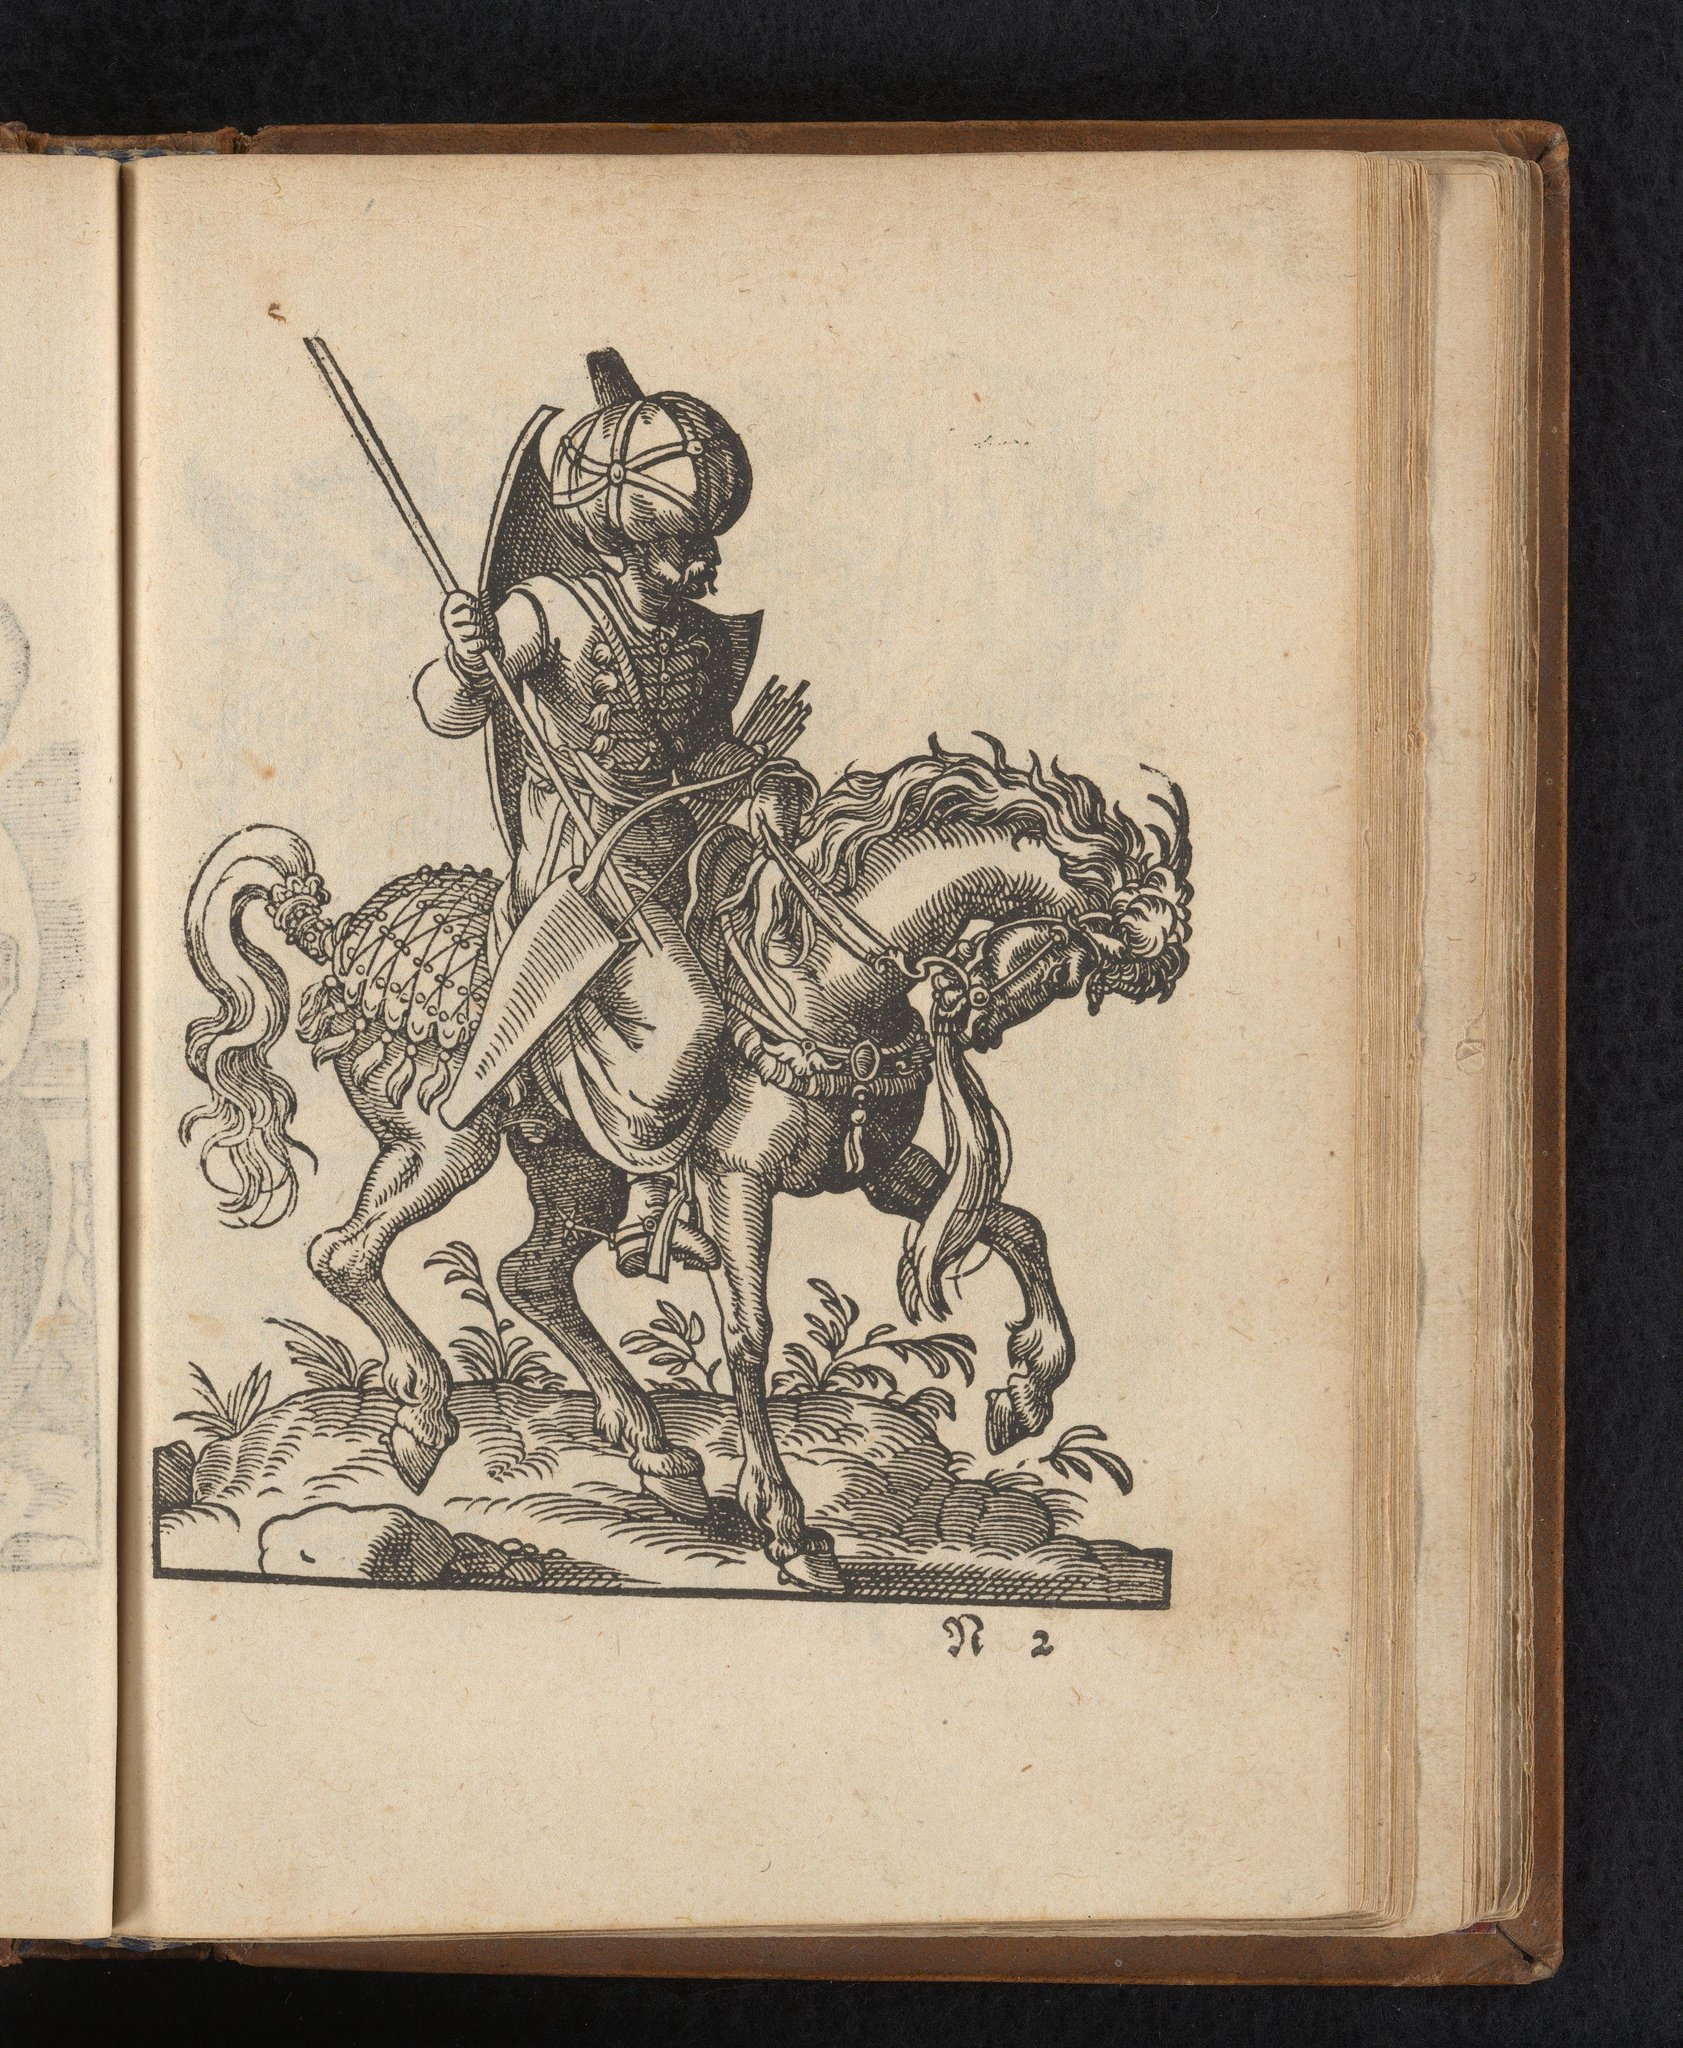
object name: print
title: Ottomaanse ruiter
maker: Anonymous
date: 1578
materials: paper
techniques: woodcut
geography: nuremberg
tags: riding a horse, ass, or mule; rider, horseman, division of armed forces (+ cavalry, horsemen)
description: Ottomaanse krijger te paard. Onderdeel van het modelboek Enchiridion artis pingendi, fingendi & sculpendi met 108 figuren bedoeld voor beginnende schilders, beeldhouwers en prentmakers.